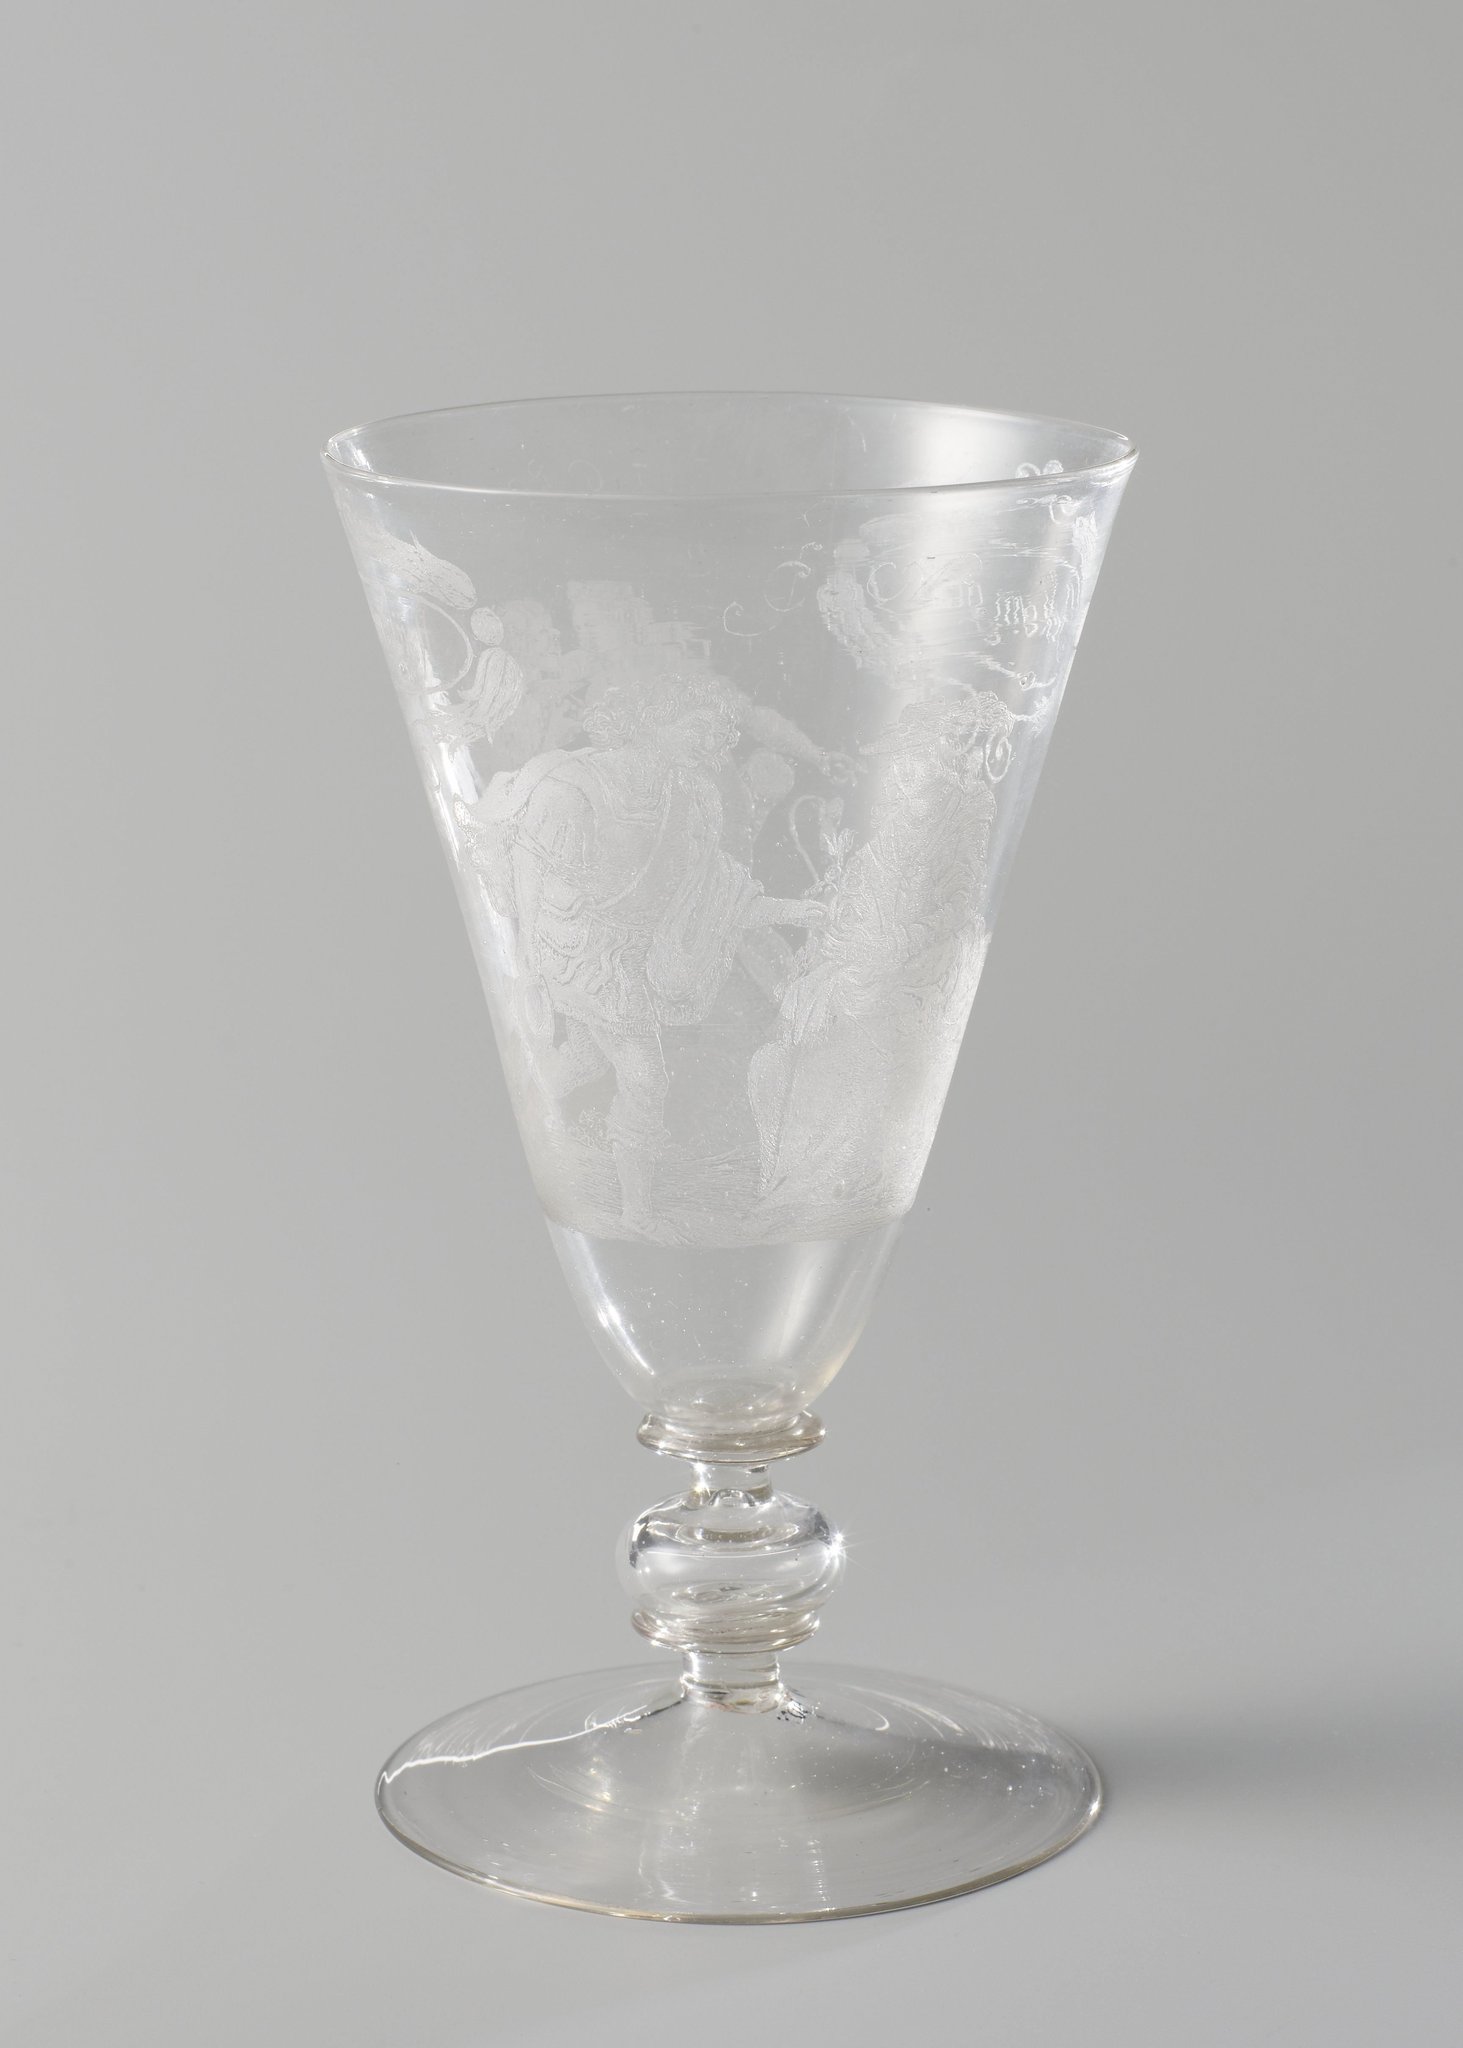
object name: goblet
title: Wine glass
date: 1652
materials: glass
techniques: diamond point engraving, glassblowing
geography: northern netherlands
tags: satyr(s) (in general), amorousness, desire, lovers; courting, flirting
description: The images contrast love given freely with love that is paid for. The inscriptions translate as: ‘I for love’ and ‘I for money’.